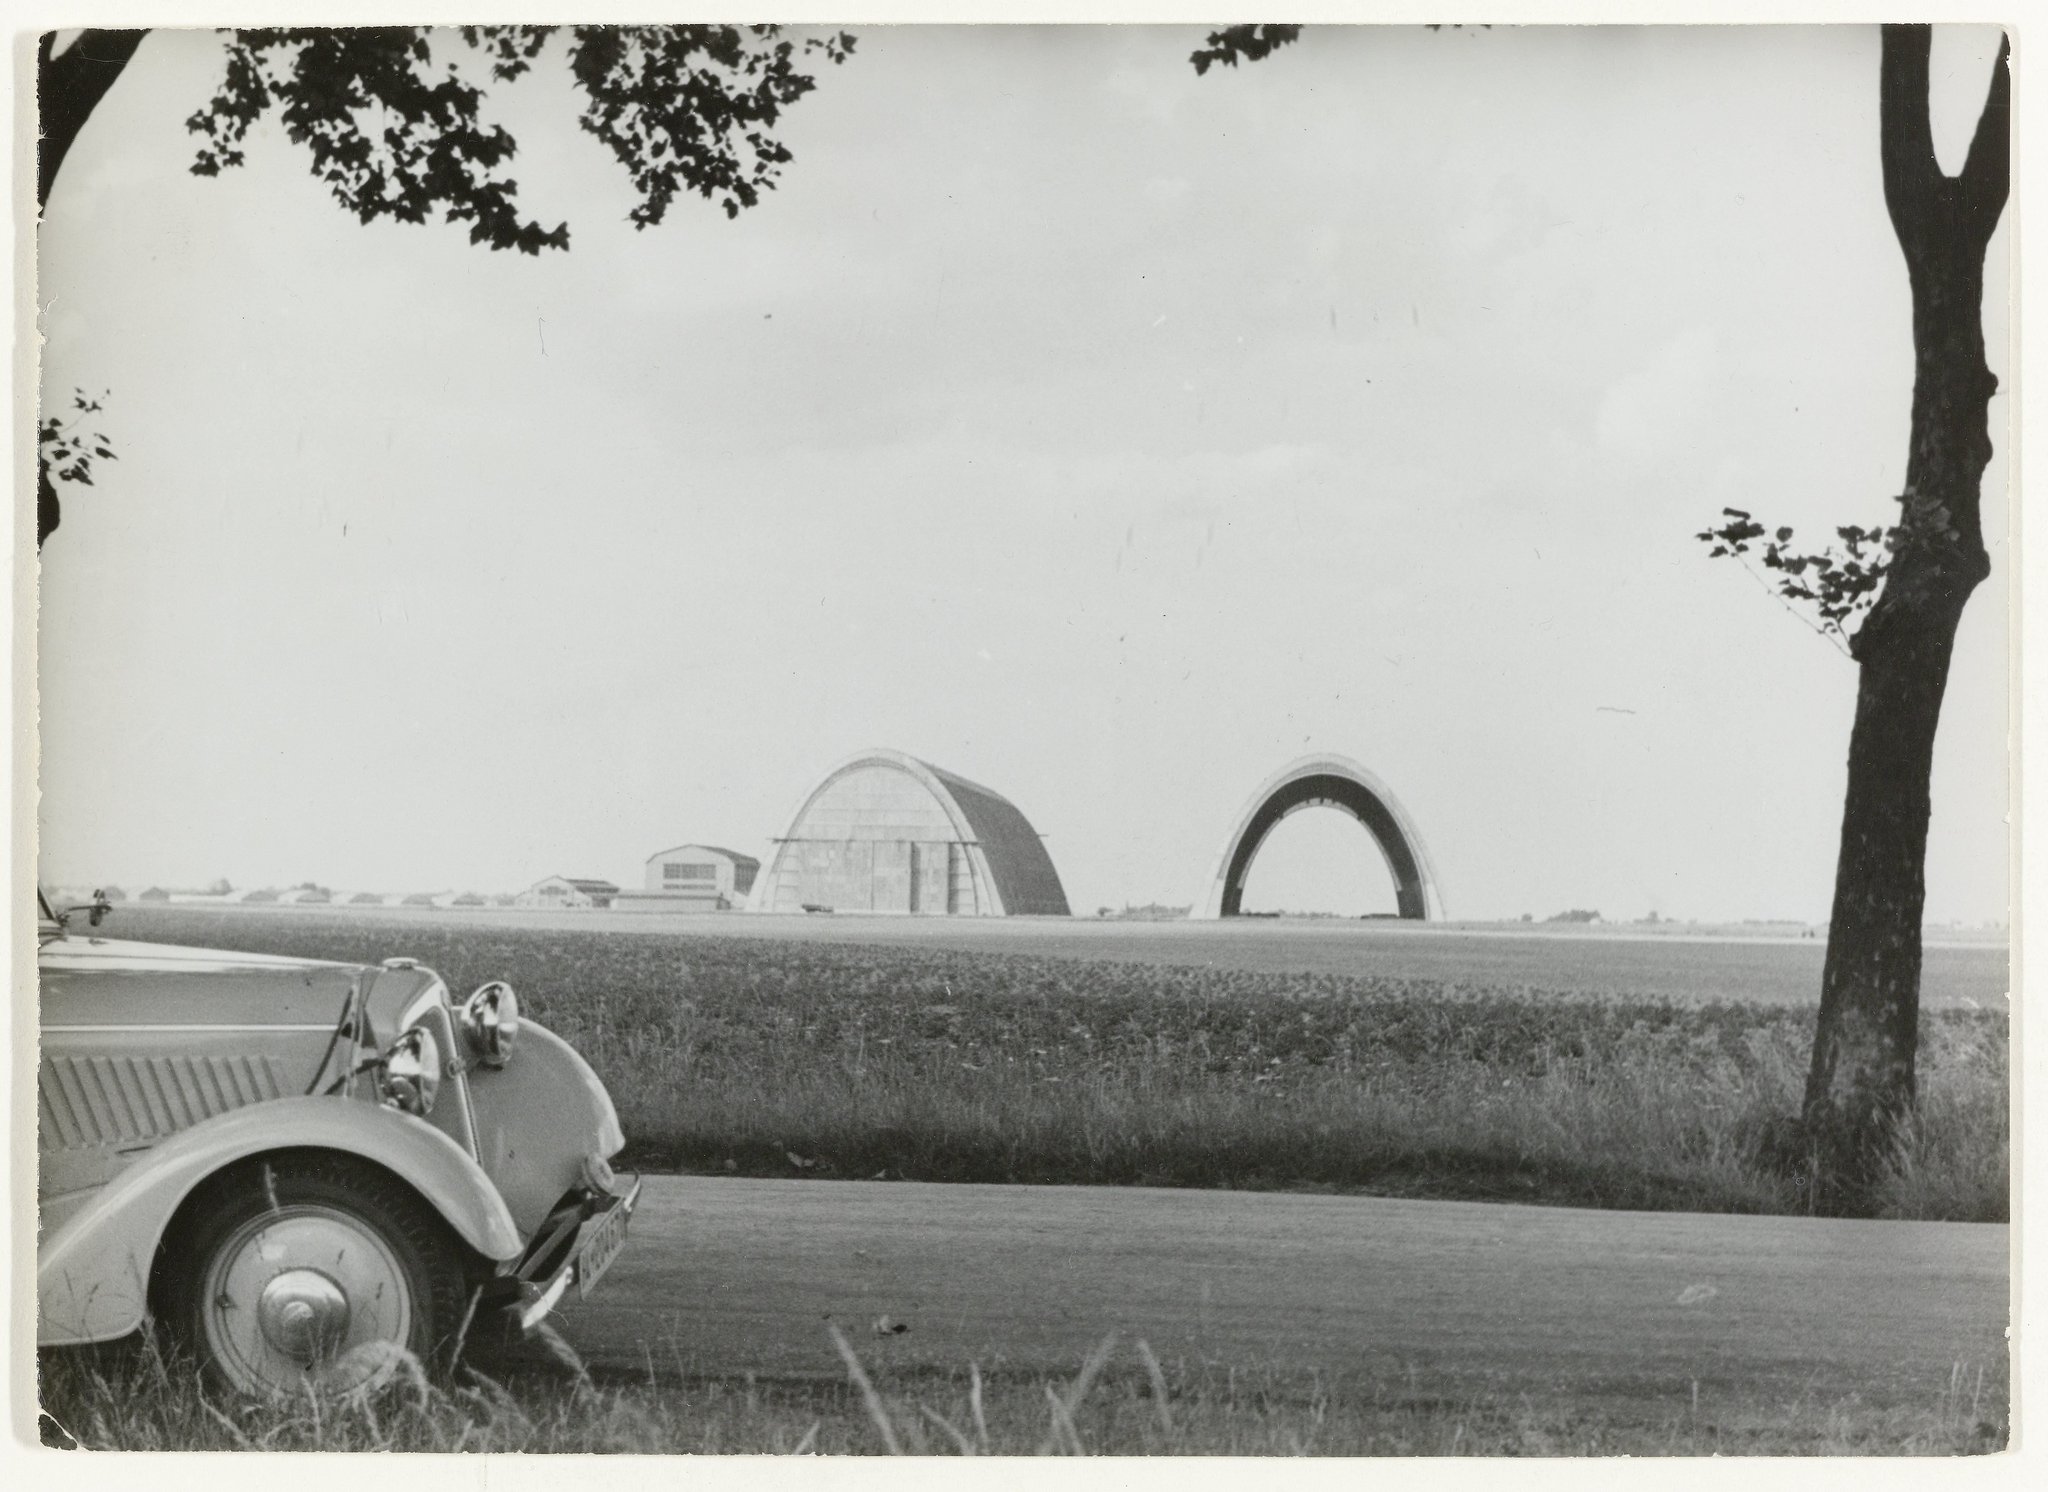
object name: photograph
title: De Graf Zeppelin II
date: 1936-1937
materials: photographic support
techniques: photography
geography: germany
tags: germany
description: Hal voor de bouw van zeppelins. Vermoedelijk in de plaats Löwenthal. Links is nog een neus van een auto te zien. Het bijschrift vermeldt dat het om het "Luftschiff" L. Z. 130, de Graf Zeppelin II gaat. Dit is de opvolger van de L. Z. 129, de Hindenburg. Deze werd in 1936 gebouwd en ging in 1937 in vlammen op tijdens zijn vlucht naar New York.